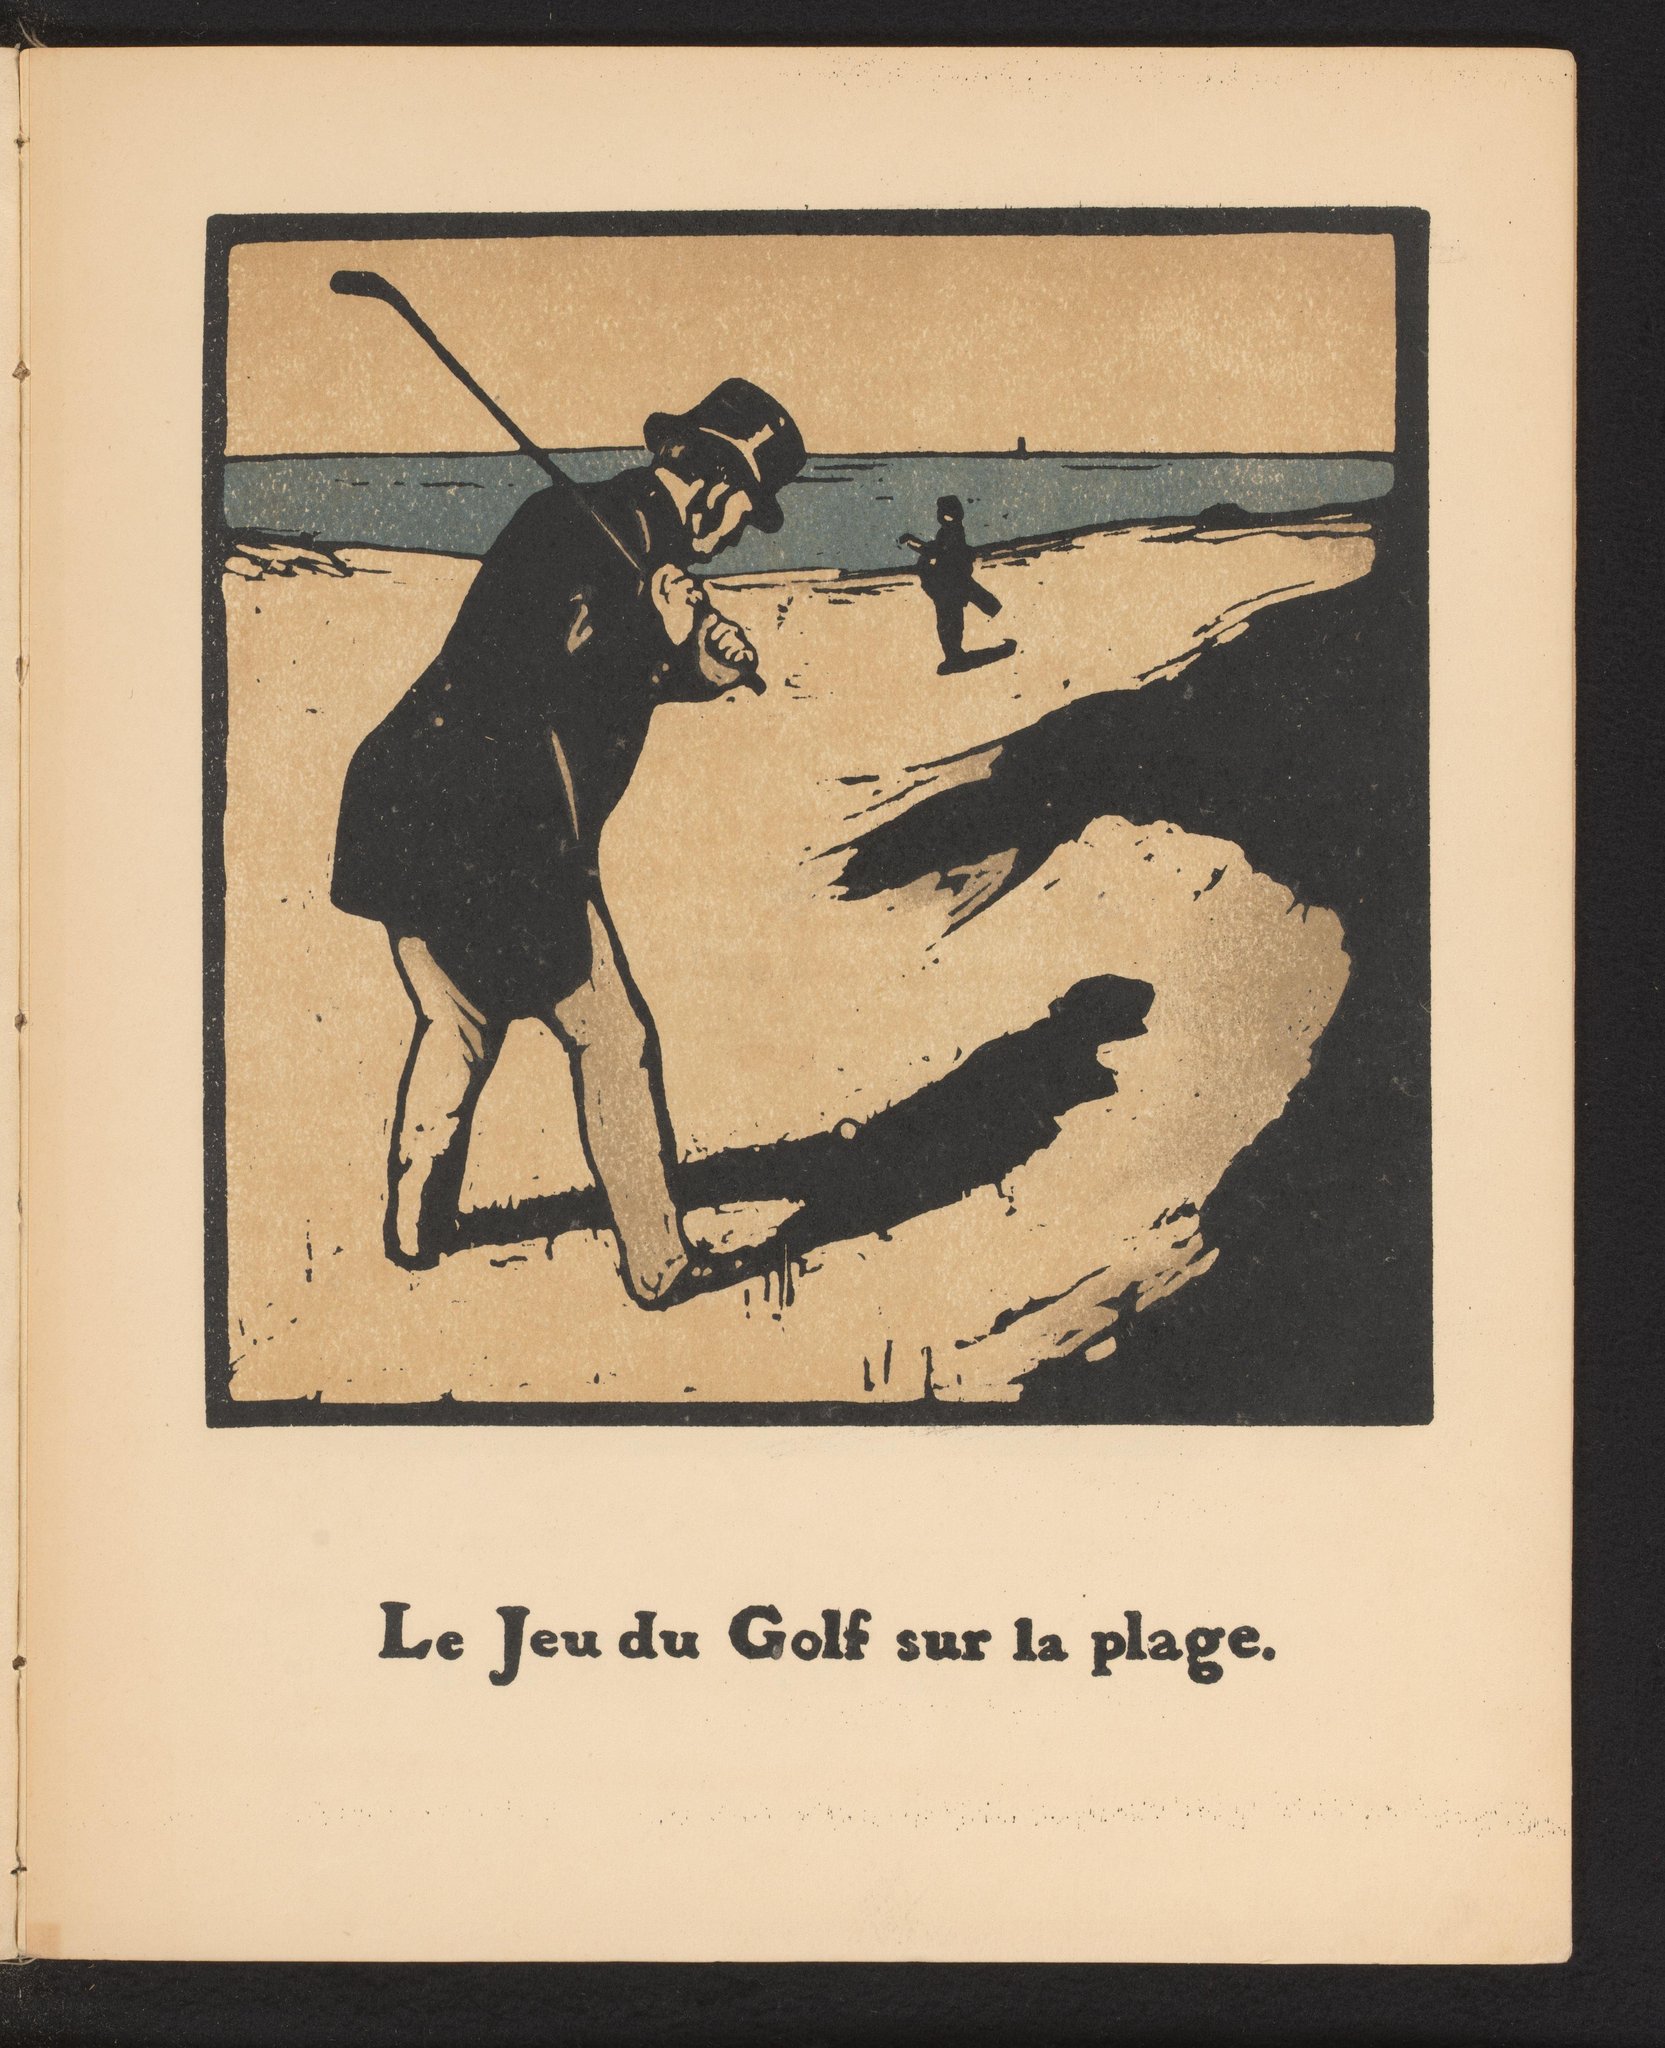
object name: print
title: Almanak met twaalf sporten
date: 1898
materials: paper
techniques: lithograph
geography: paris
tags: calendar, almanac, golf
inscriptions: : ‘Novembre./ Dimanche - 6 13 20 27/ Lundi - 7 14 21 (...)’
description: Prent maakt deel uit van een boek. Illustratie bij kalendermaand op tegenoverliggende blad.